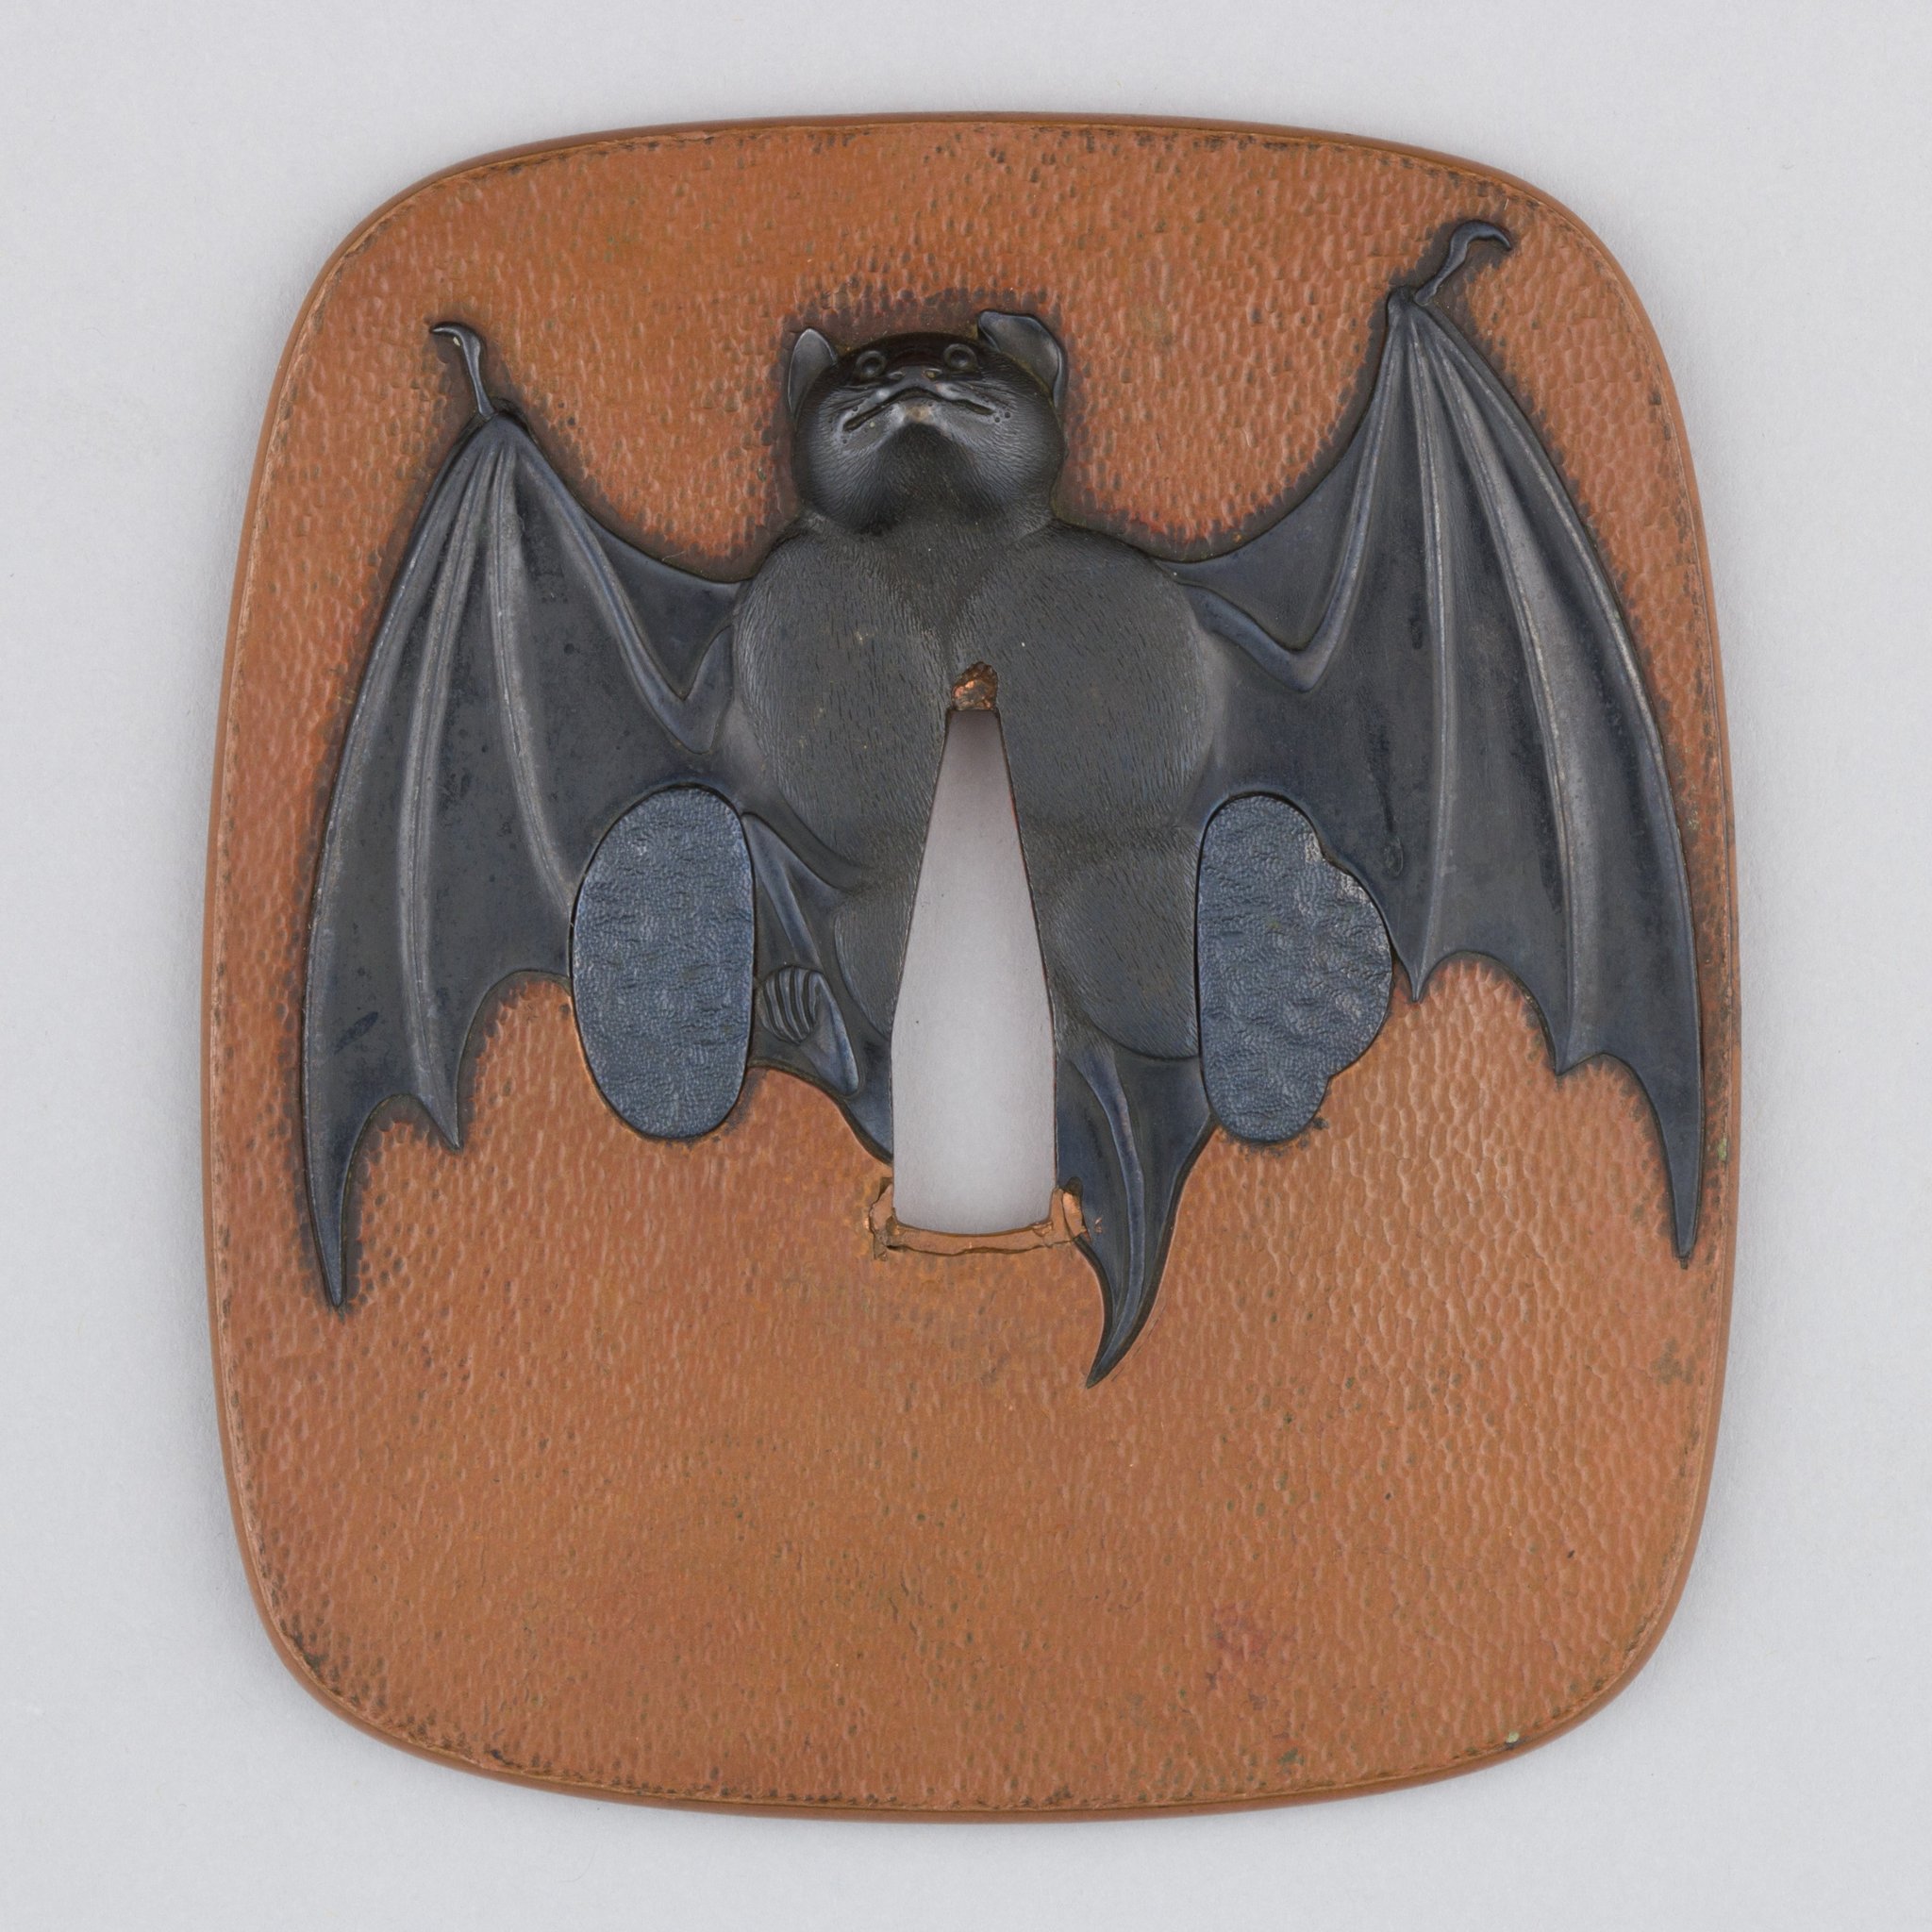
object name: sword guard tsuba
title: Sword Guard (Tsuba)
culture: japanese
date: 1615-1868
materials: copper, gold alloy, silver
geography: japan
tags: bats